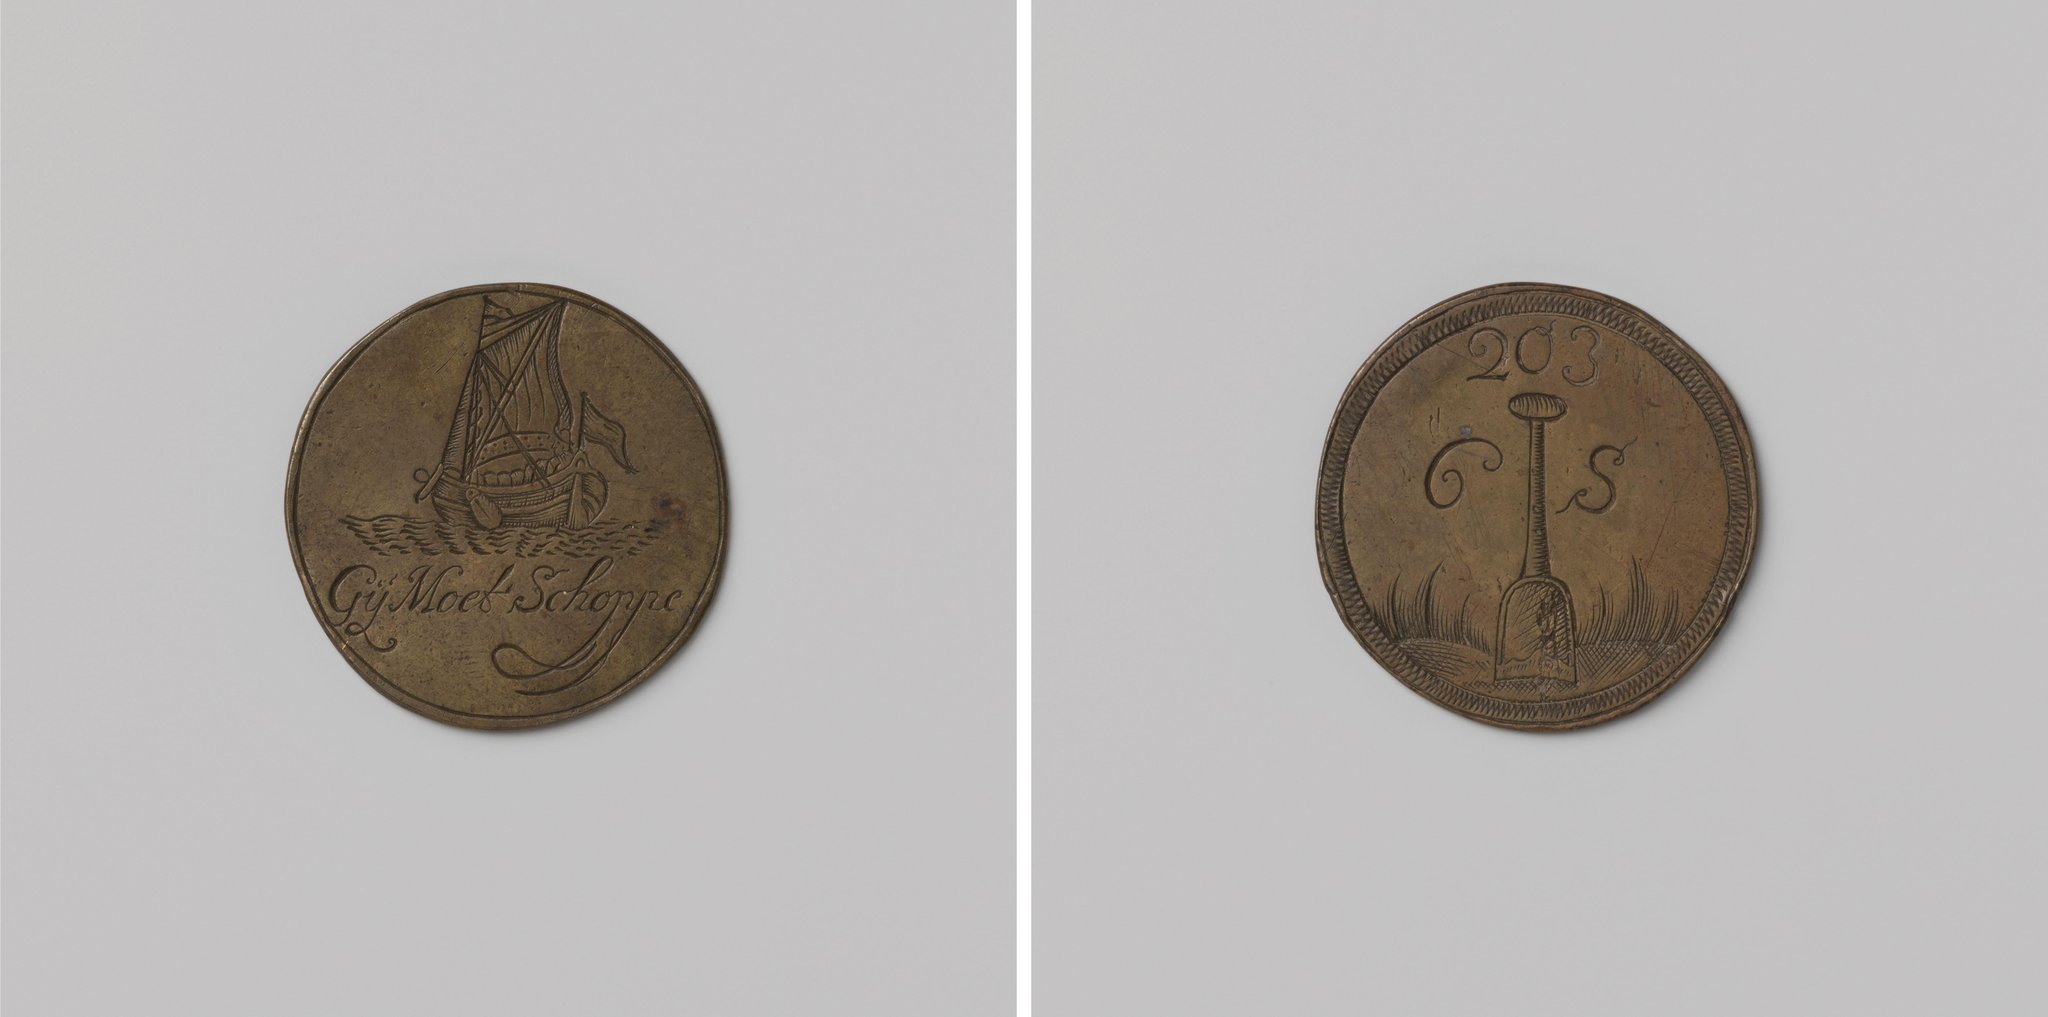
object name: ontgrondingspenning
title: Ontgronding met no. 203, penning bedoeld als bewijs voor turfdragers, -vullers of -tonners om turf in te mogen voeren uit de nieuw ontgronde venen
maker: Anonymous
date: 1769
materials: brass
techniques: engraving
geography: rotterdam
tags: rotterdam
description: Messing penning. Voorzijde: naar links varend schip boven opschrift: "Gij Moet Schoppe". Keerzijde: spade tussen letters G en S onder cijfer 203.